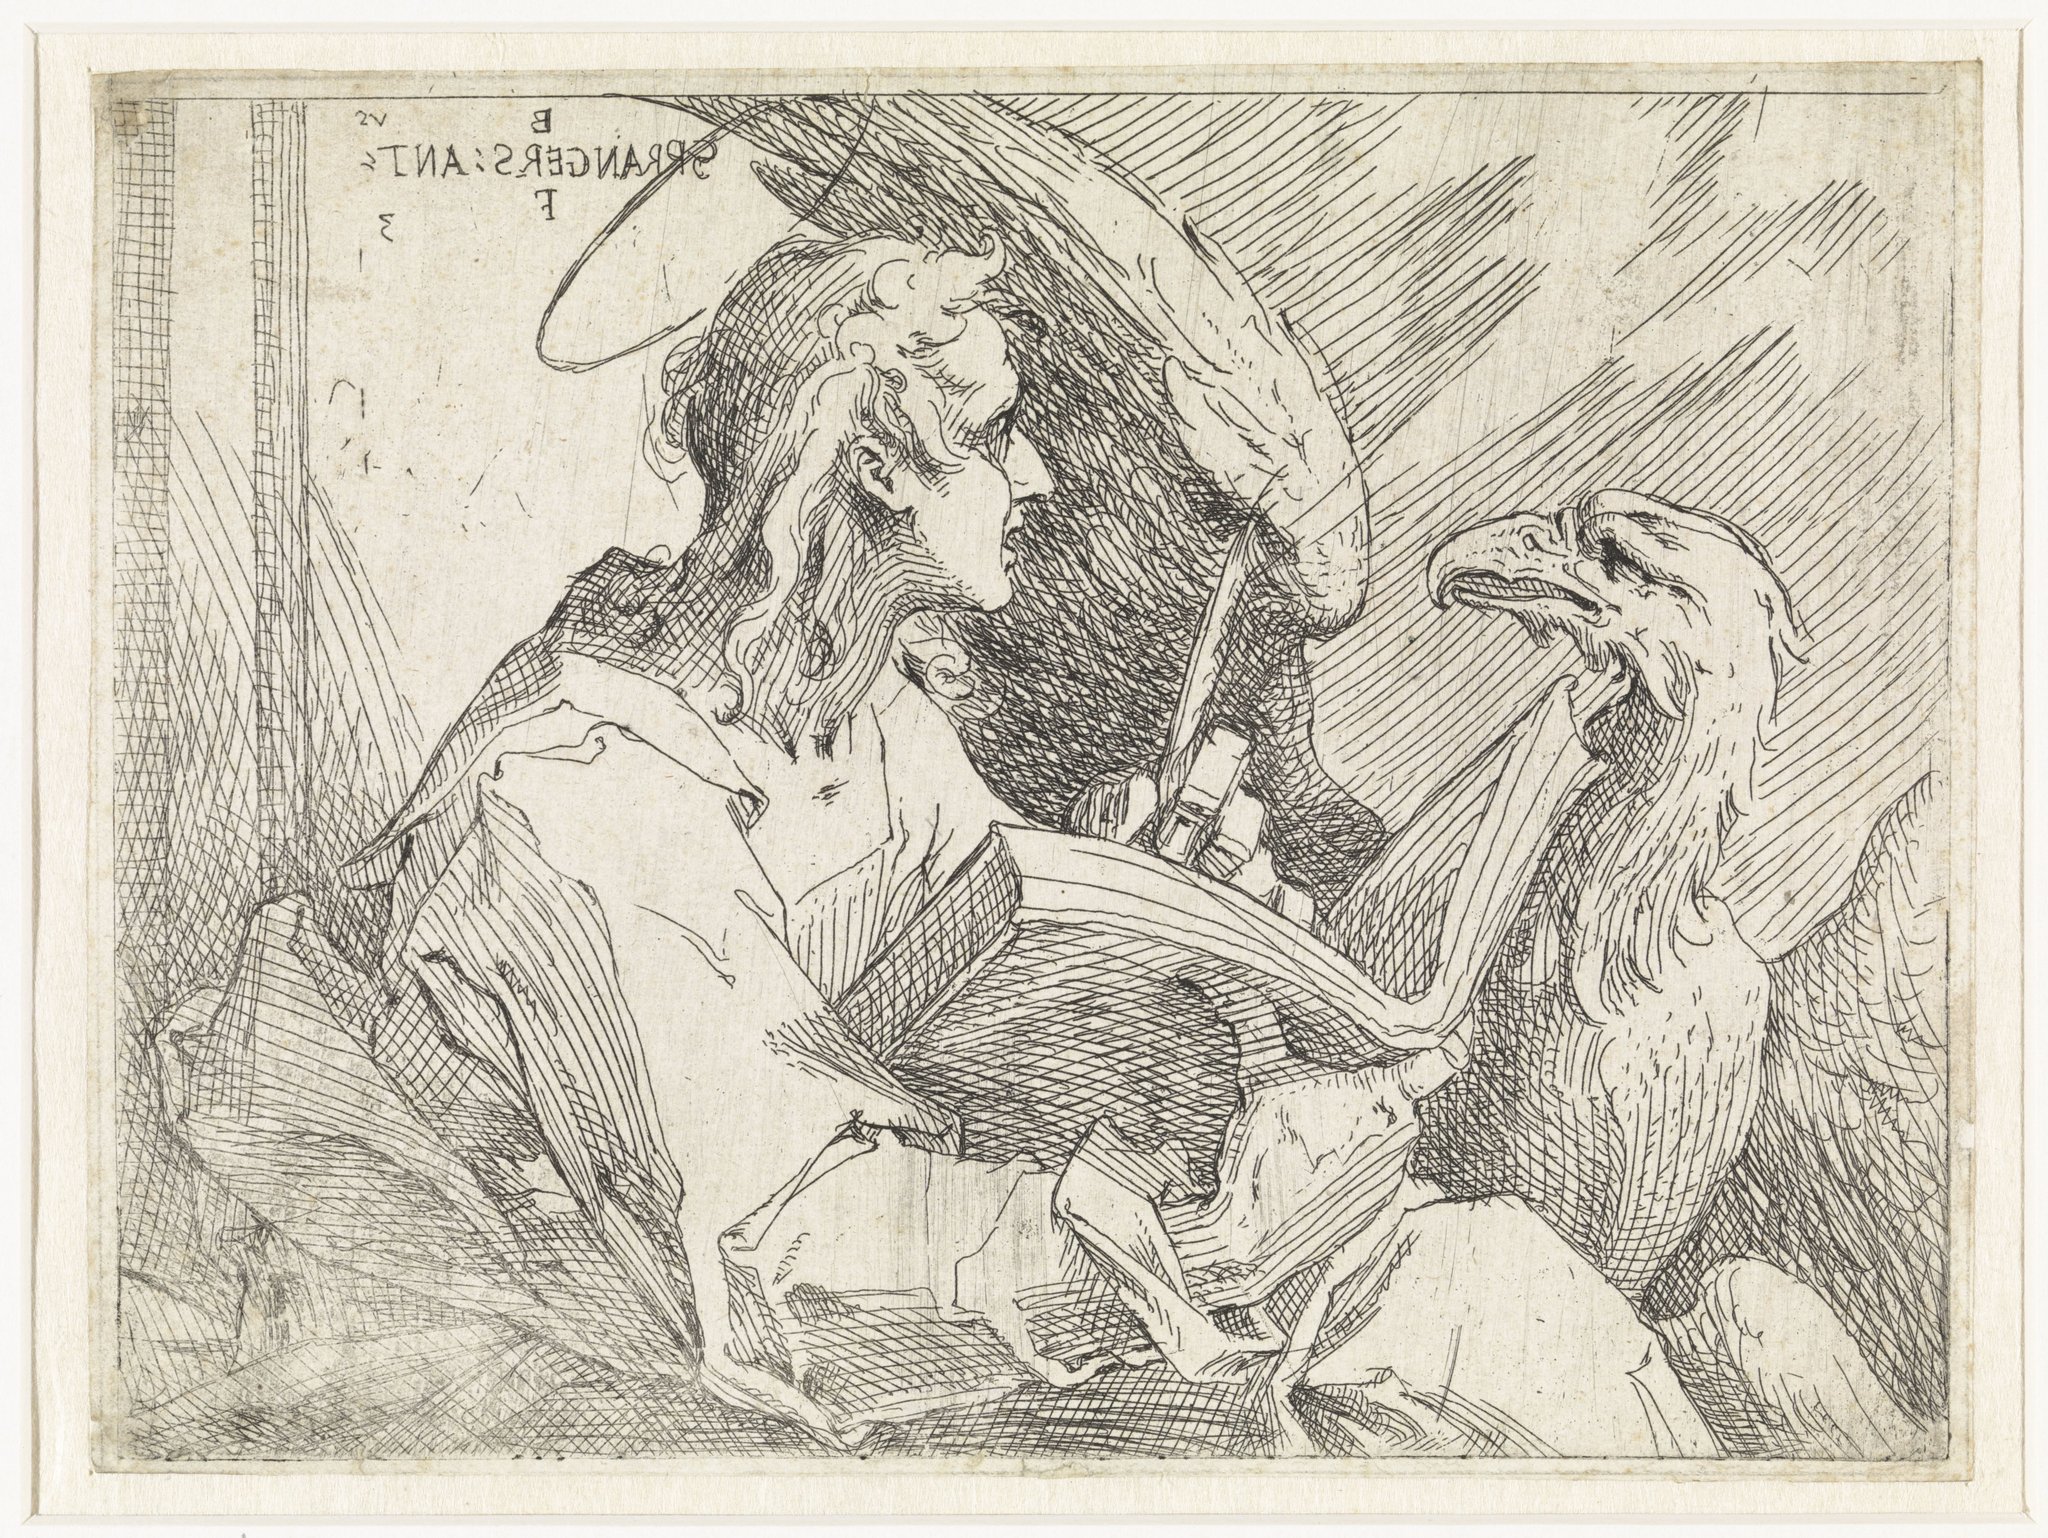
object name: print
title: Johannes de Evangelist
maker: bartholomeus spranger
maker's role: draughtsman, painter, print maker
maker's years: 1546-1611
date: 1557-1564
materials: paper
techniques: etching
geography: antwerp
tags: the apostle john the evangelist; possible attributes: book, cauldron, chalice with snake, eagle, palm, scroll, eagle (possibly with book) ~ symbol of st. john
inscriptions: collector's mark: Lugt 2228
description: Johannes de Evangelist schrijft met een schrijfveer het evangelie, terwijl naast hem zijn atribuut, de adelaar, zit.